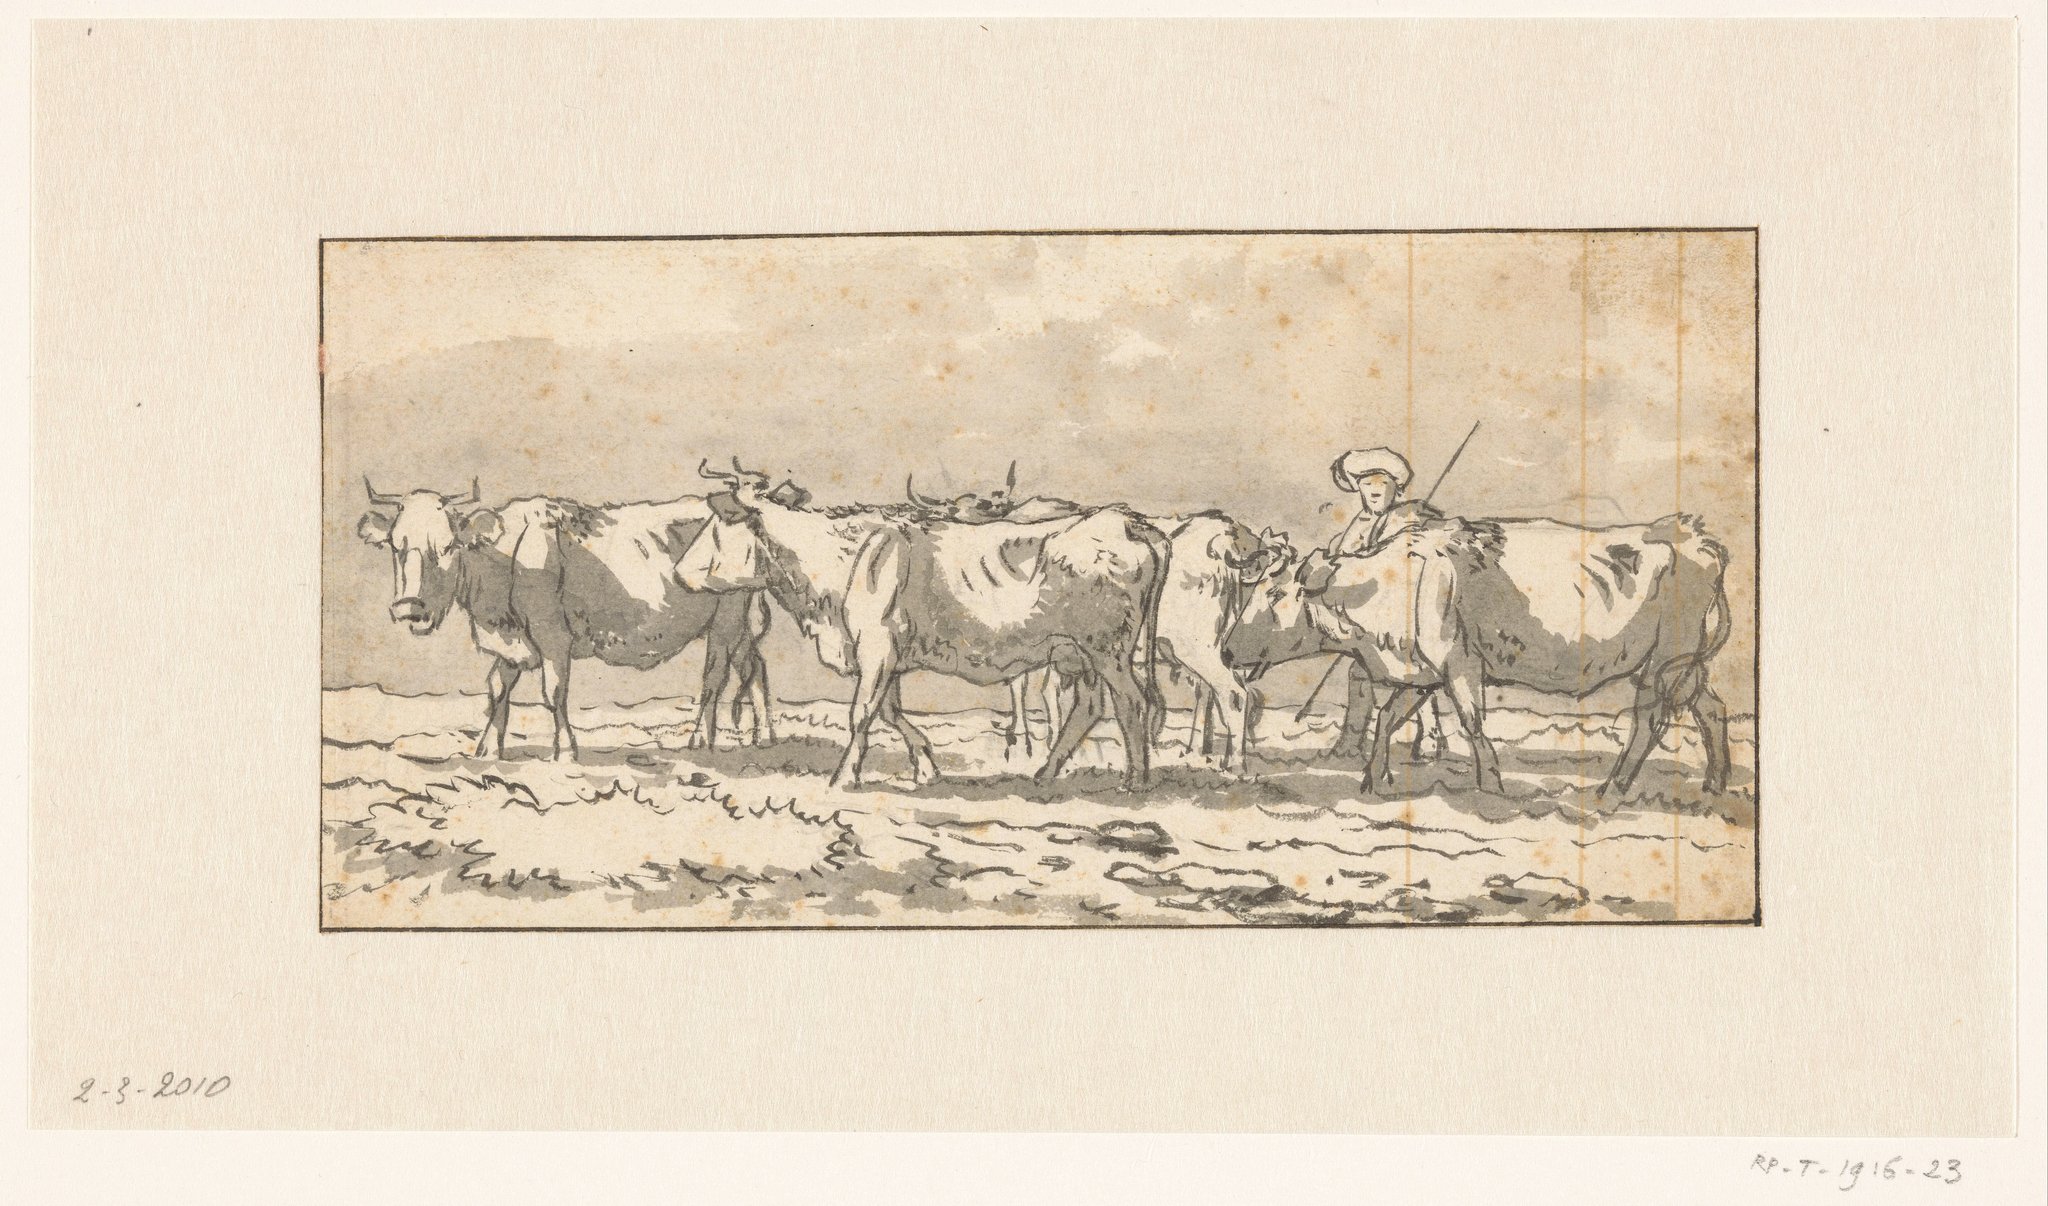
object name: drawing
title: Herder met kudde koeien in de wei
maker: wouter johannes van troostwijk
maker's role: draughtsman, painter, print maker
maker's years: 1782-1810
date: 1792-1810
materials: ink, paper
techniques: brush, pen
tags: cow, meadow, pasture